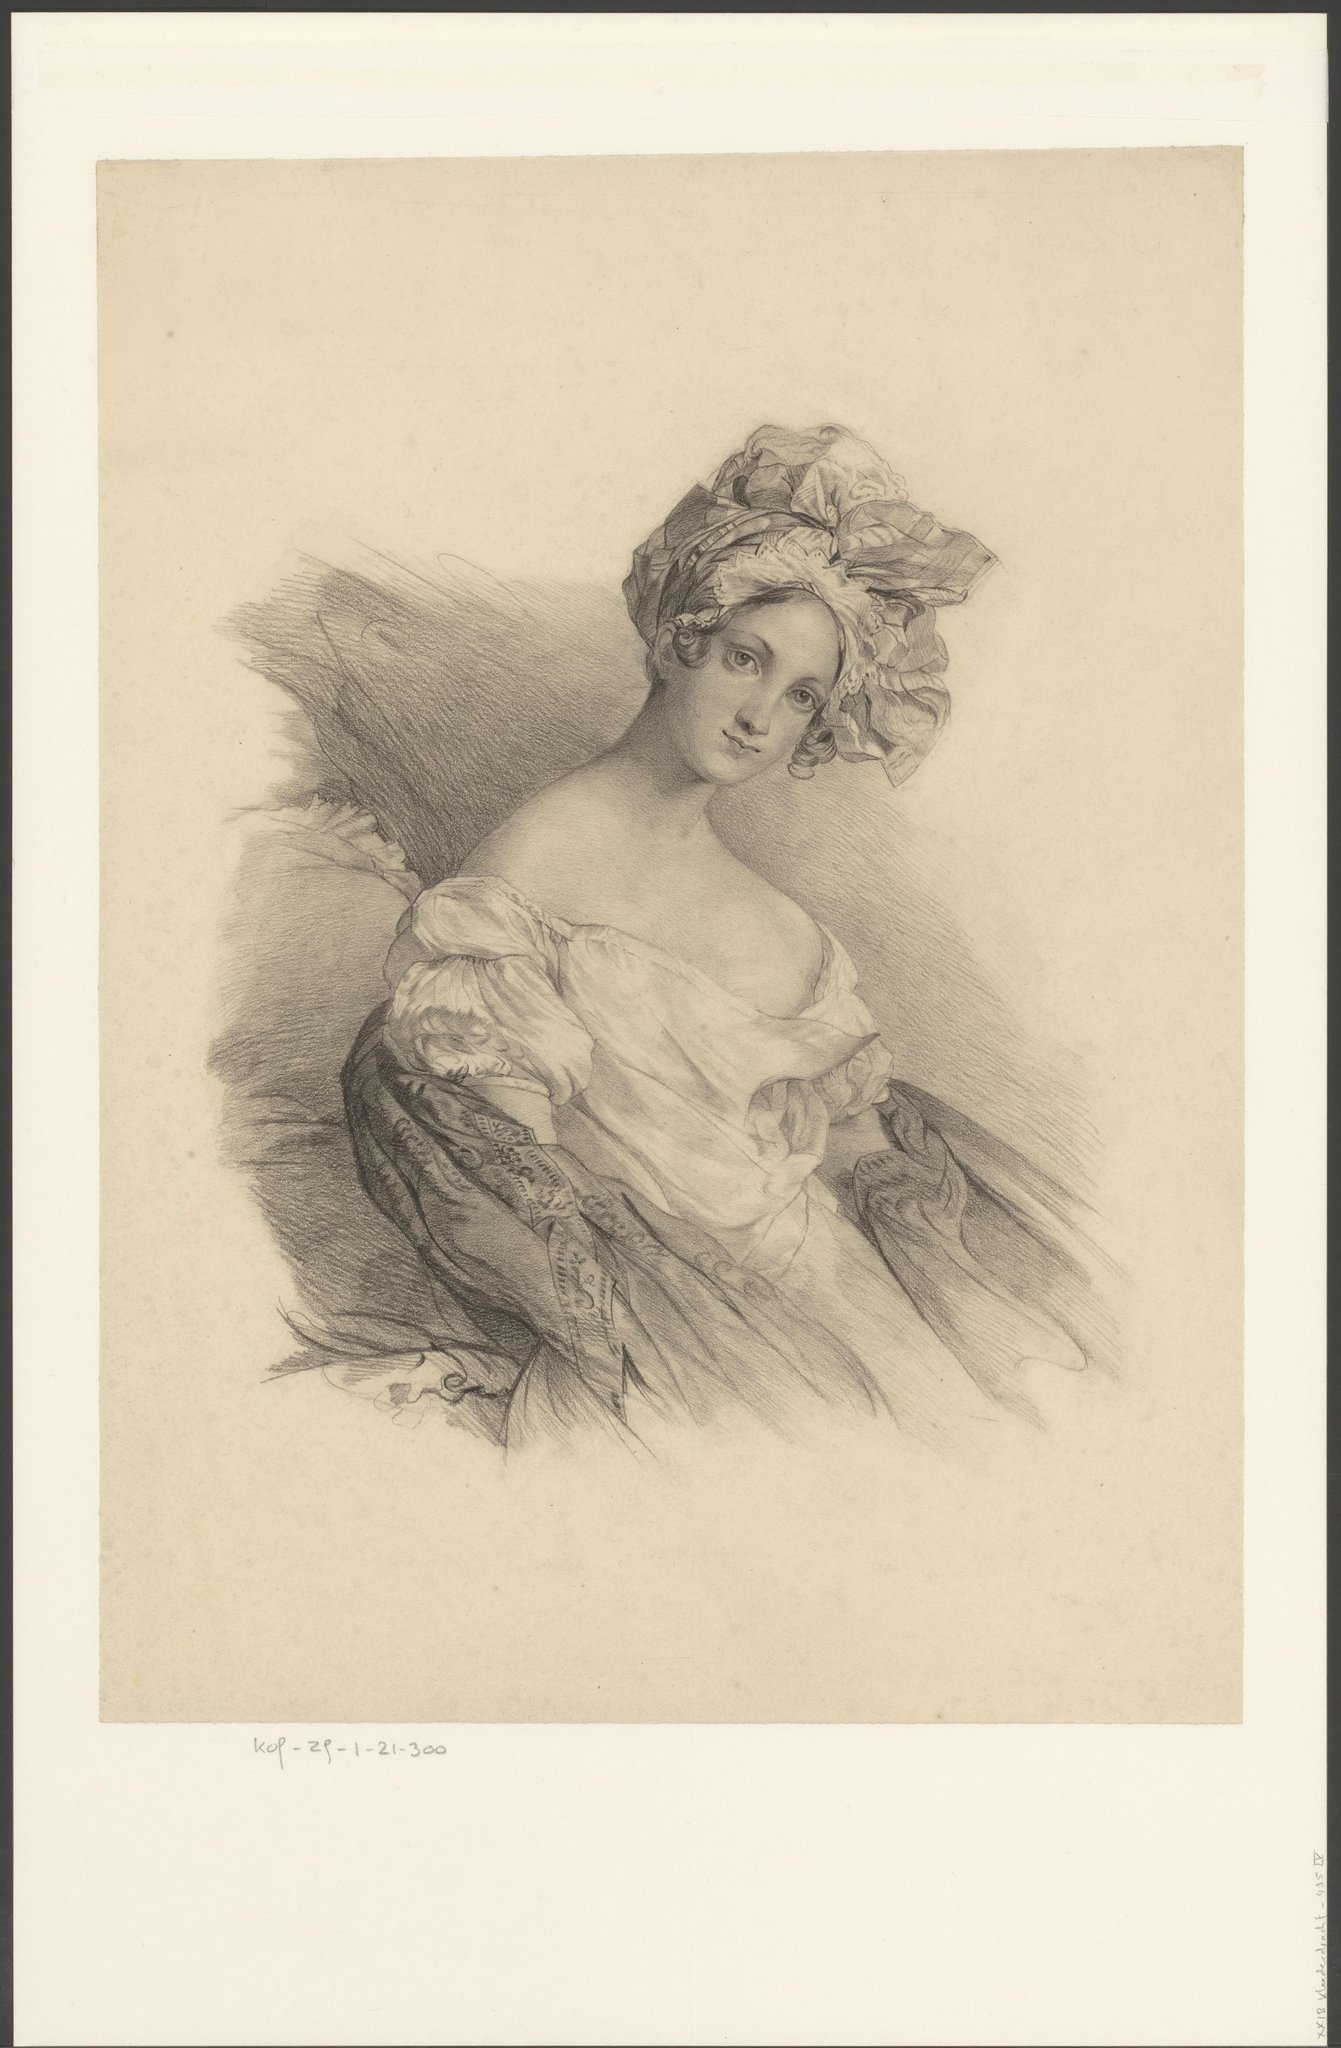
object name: drawing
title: Dame in bed in nachtkleding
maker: Anonymous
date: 1850-1870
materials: chalk, paper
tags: adult woman, nightwear: night-gown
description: Onderwerpsrubrieken binnen de Atlas Zeden en Gewoonten: Zeden en Gewoonten in Engeren Zin, De Kleeding, Kleederdrachten (tijdvakken), De crinolinetijd.